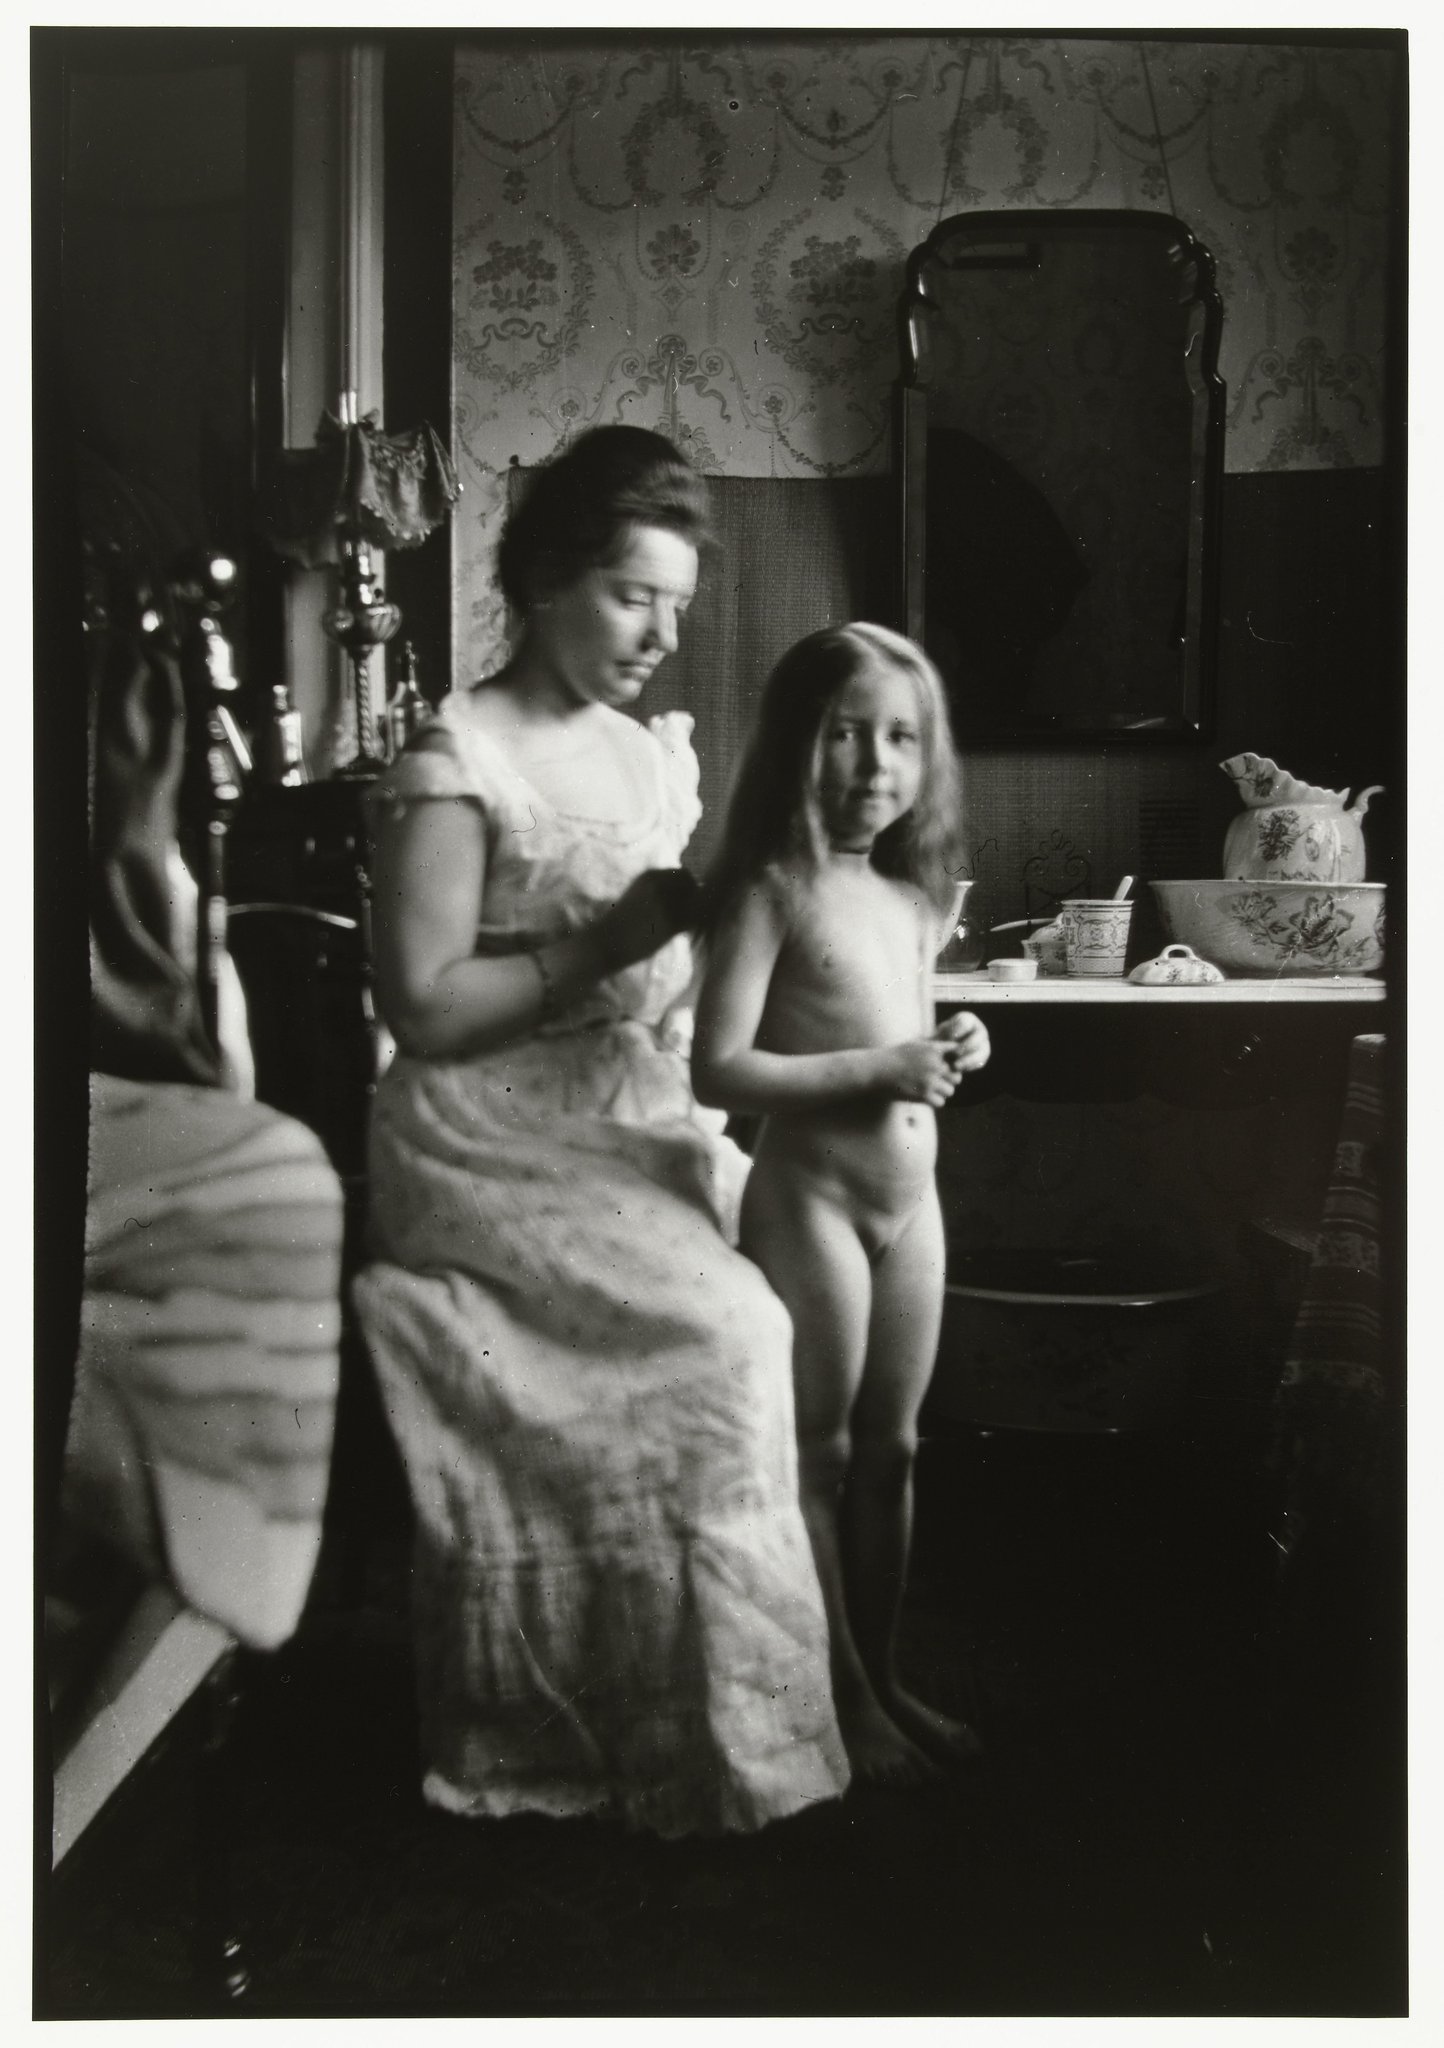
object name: photograph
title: Portret van Marie Breitner die een meisje helpt bij het haarkammen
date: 1890-1910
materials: paper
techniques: gelatin silver print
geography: amsterdam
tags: marie jordan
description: Moderne afdruk van negatief BR 1525 (collectie RKD).